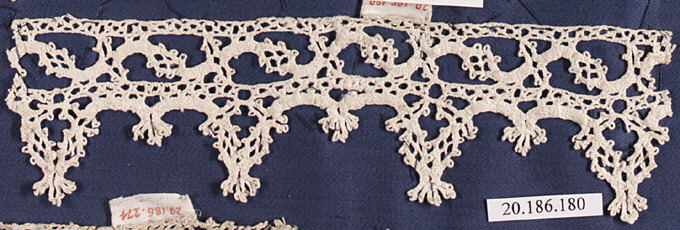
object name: edging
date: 1501-1600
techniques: lace